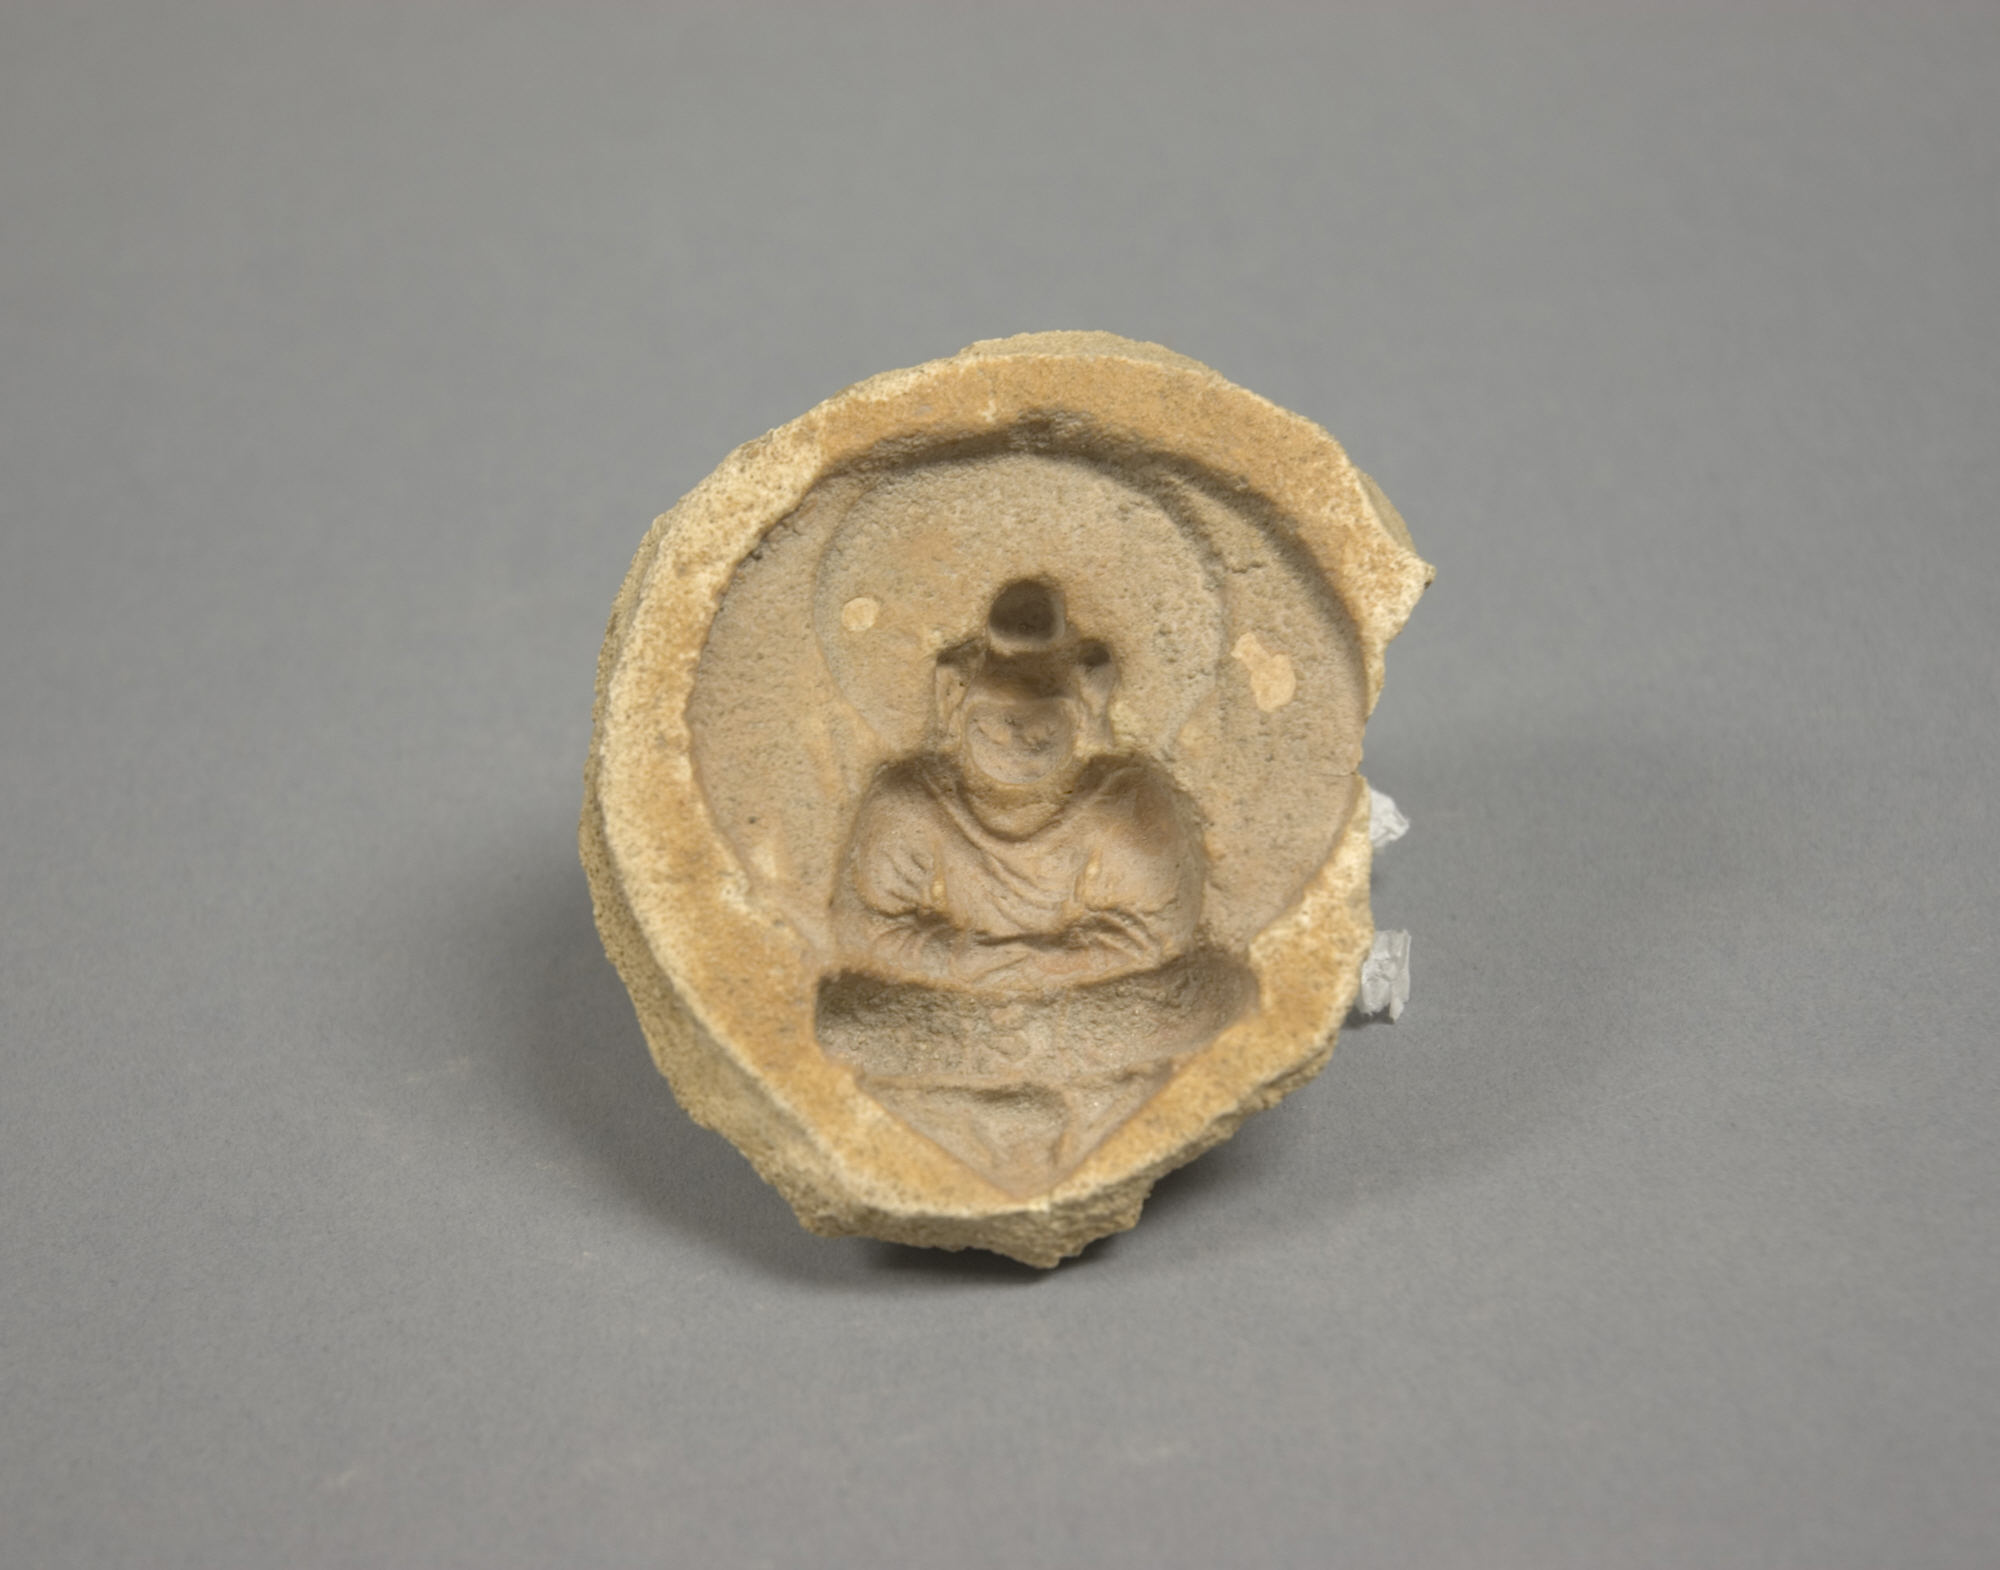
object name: mold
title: Mold with Intaglio Figure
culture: central asian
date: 201-700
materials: plaster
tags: human figures